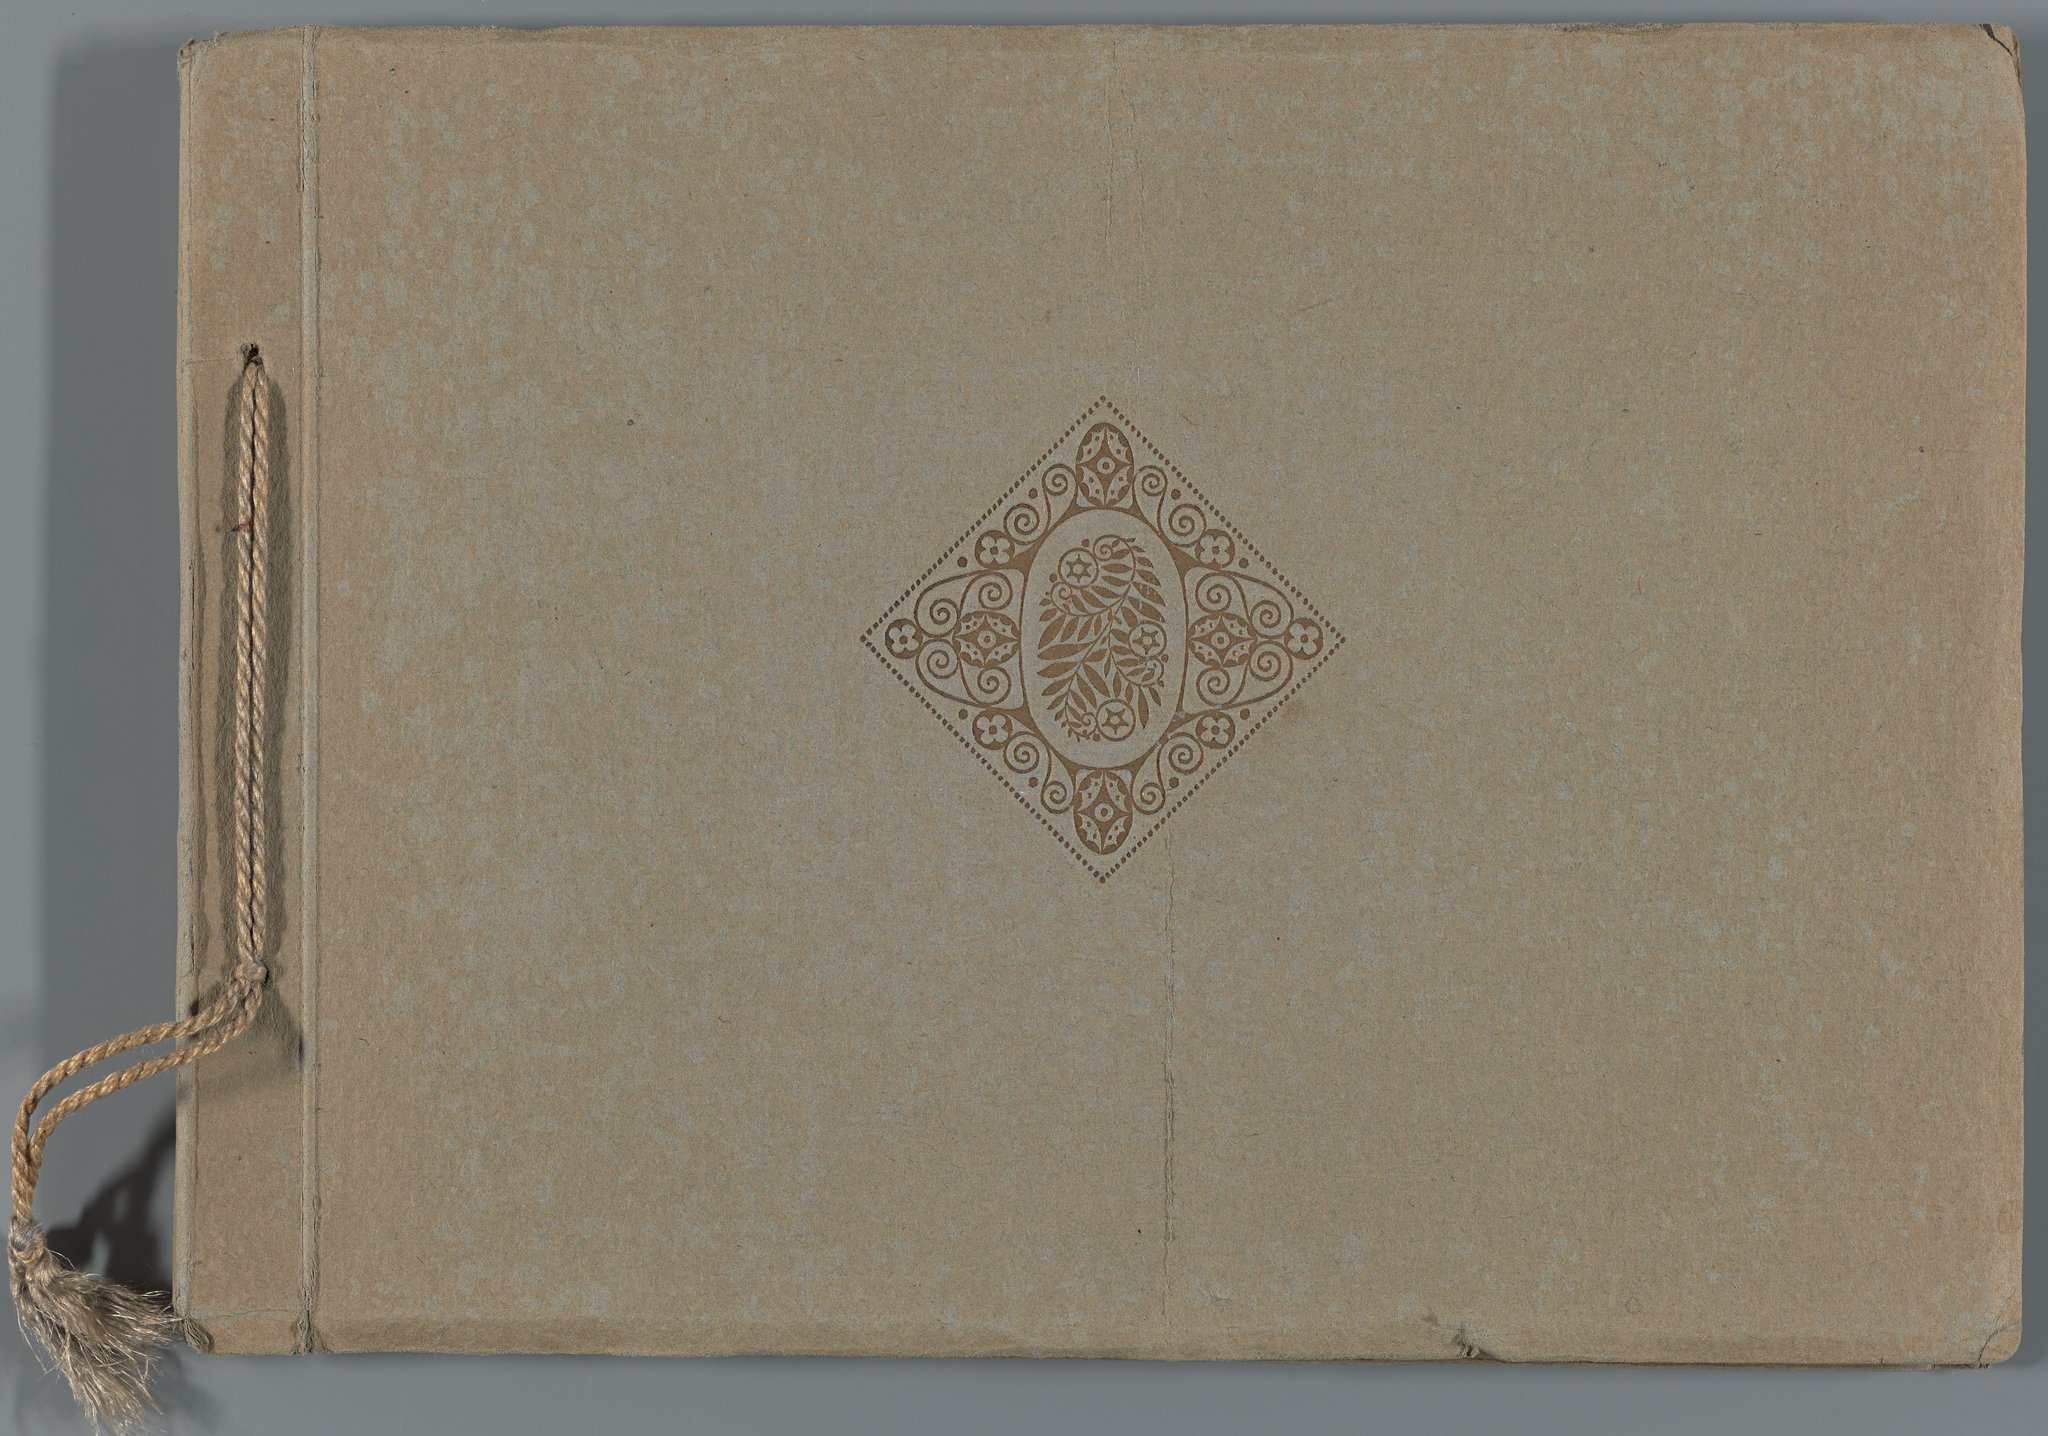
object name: slip in album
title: Fotoalbum van Charlotte Boelen-Matthes met opnames van haar dochters Eva en Hettie uit de periode 1922-1923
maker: charlotte alida boelen-matthes (lot)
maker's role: amateurfotograaf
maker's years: 1889-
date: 1922-1923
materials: cardboard, paper, photographic support, fiber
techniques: gelatin silver print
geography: netherlands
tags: eva charlotte pennink-boelen, charlotte alida boelen-matthes (lot), the family travelling, on holiday, historical persons, family life at home, netherlands, europe, bruges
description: Fotoalbum in grijsgroene kaft, doorregen met een touw. Het voorplat is versierd met een ruit in gouddruk en bladmotief. Het binnenwerk bestaat uit 12 albumbladen van karton met 24 opgeplakte of ingestoken foto's. Twee foto's werden los aangetroffen. Het betreft opnames uit de jaren ca. 1922-1923 die mogelijk gemaakt zijn door Charlotte (Lot) Alida Boelen-Matthes. Het zijn voornamelijk jeugdfoto's van haar dochters Eva en Hettie Boelen en van mensen uit hun omgeving.